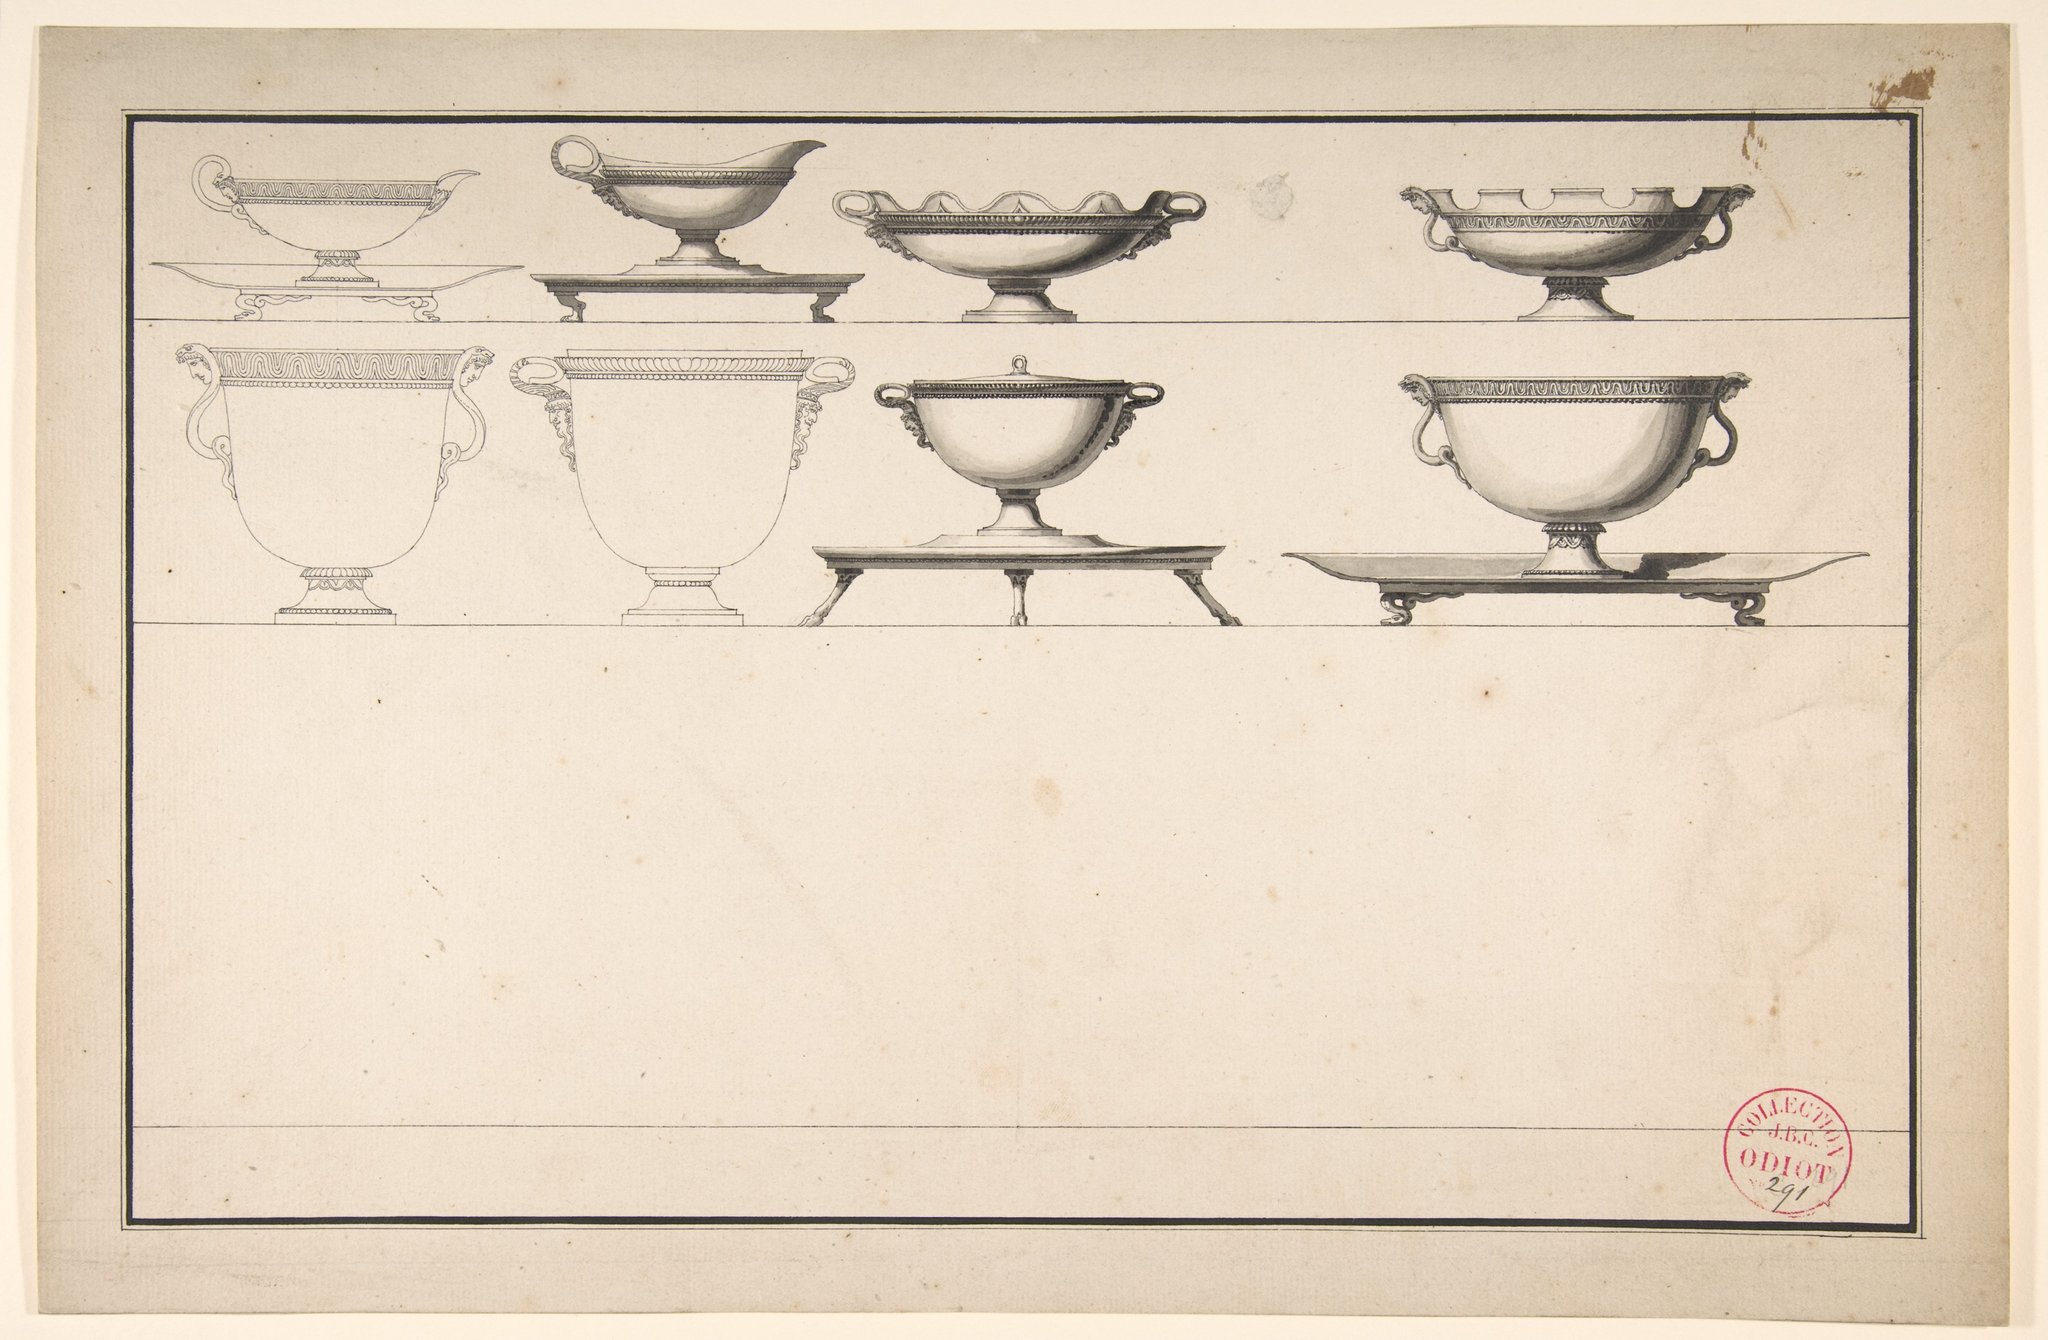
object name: drawing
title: Studies of Eight Silver Pieces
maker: jean guillaume moitte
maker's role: artist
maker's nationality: french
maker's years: 1746-1810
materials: ink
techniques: brush, pen, wash